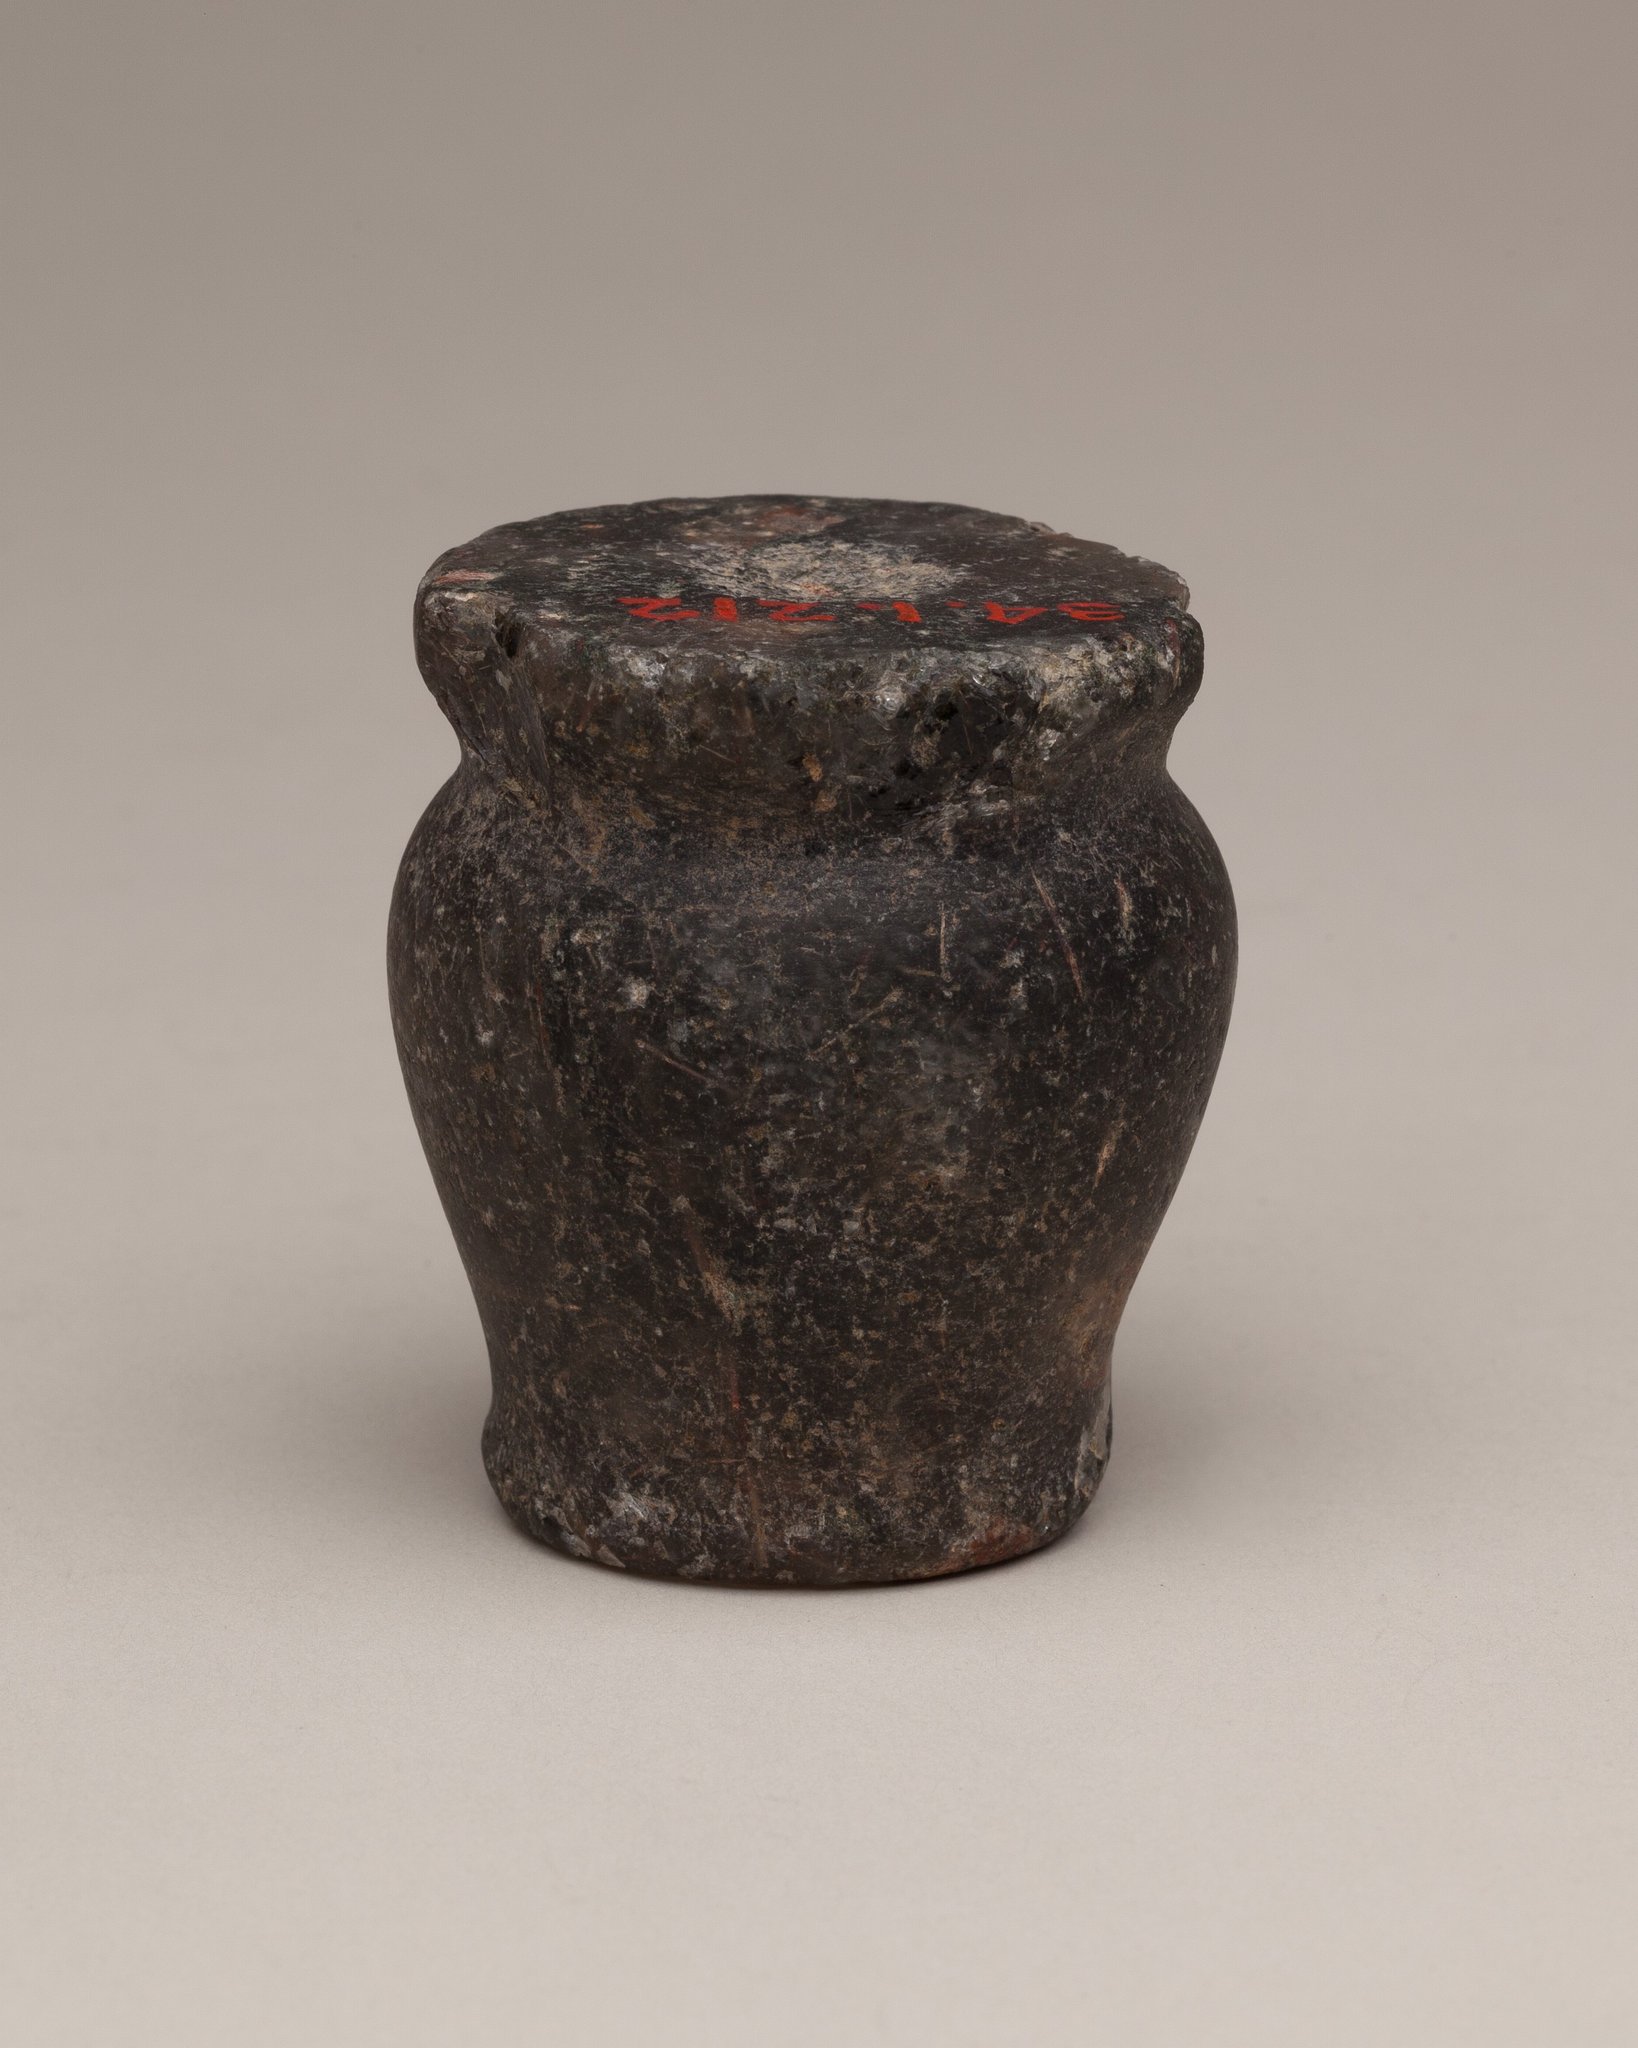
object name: kohl jar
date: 1981-1640 BCE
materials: quartz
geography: egypt